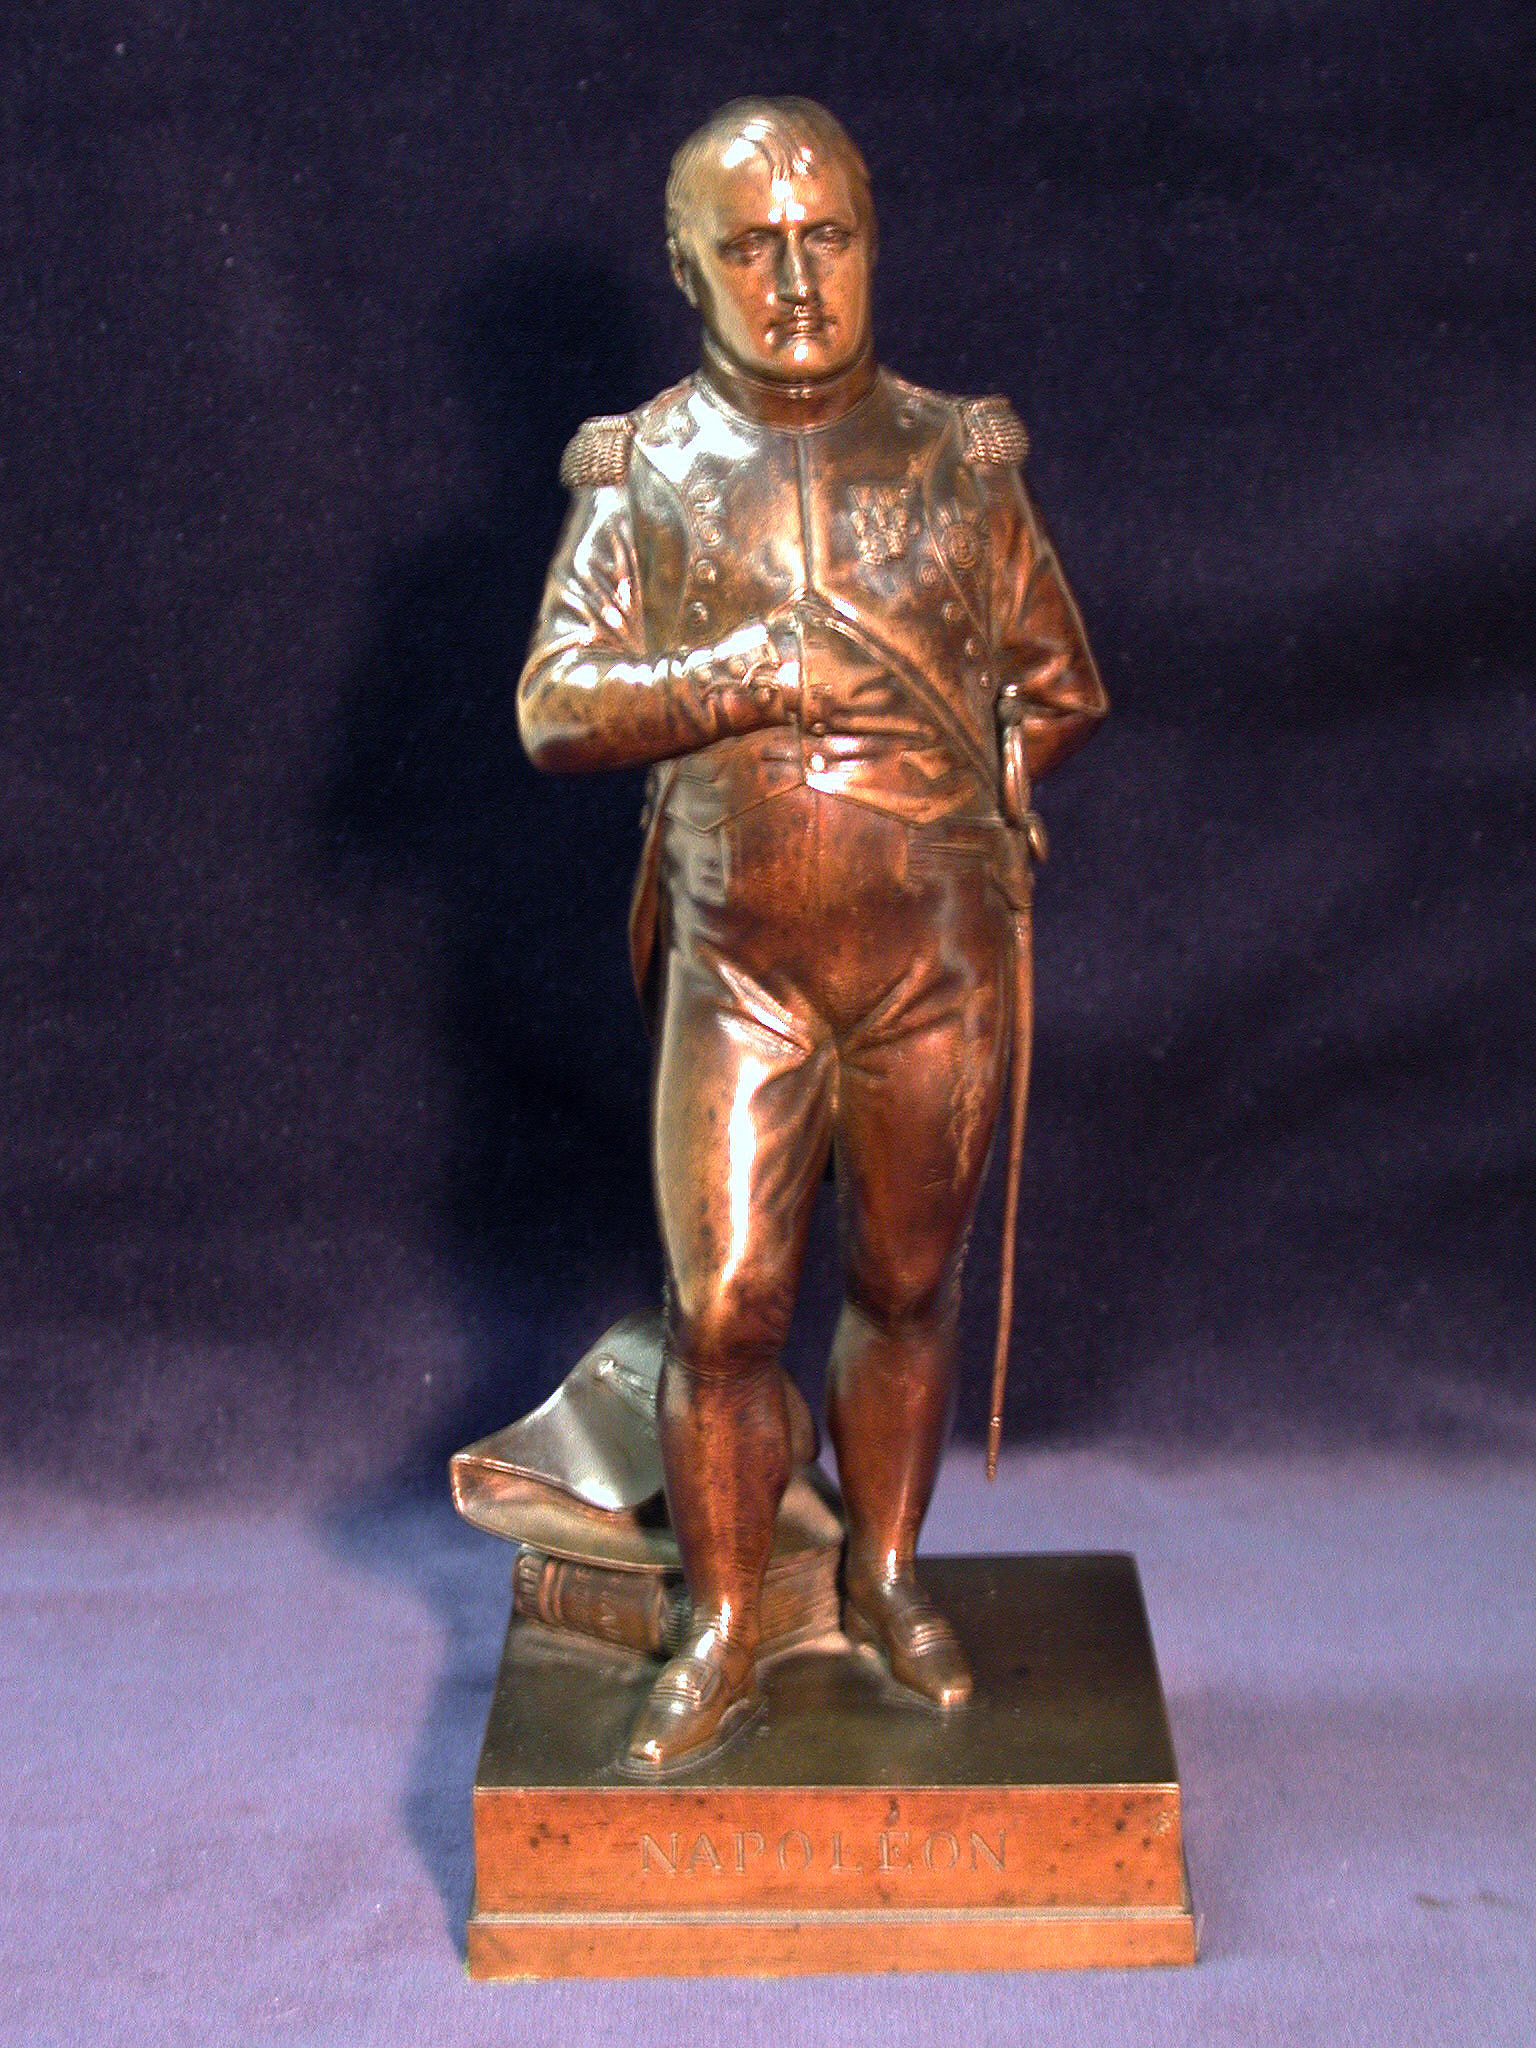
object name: statuette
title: Napoleon I (Napoléon 1er debout)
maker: jean-auguste barre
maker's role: artist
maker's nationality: french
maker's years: 1811-1896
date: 1838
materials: bronze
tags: napoleon i